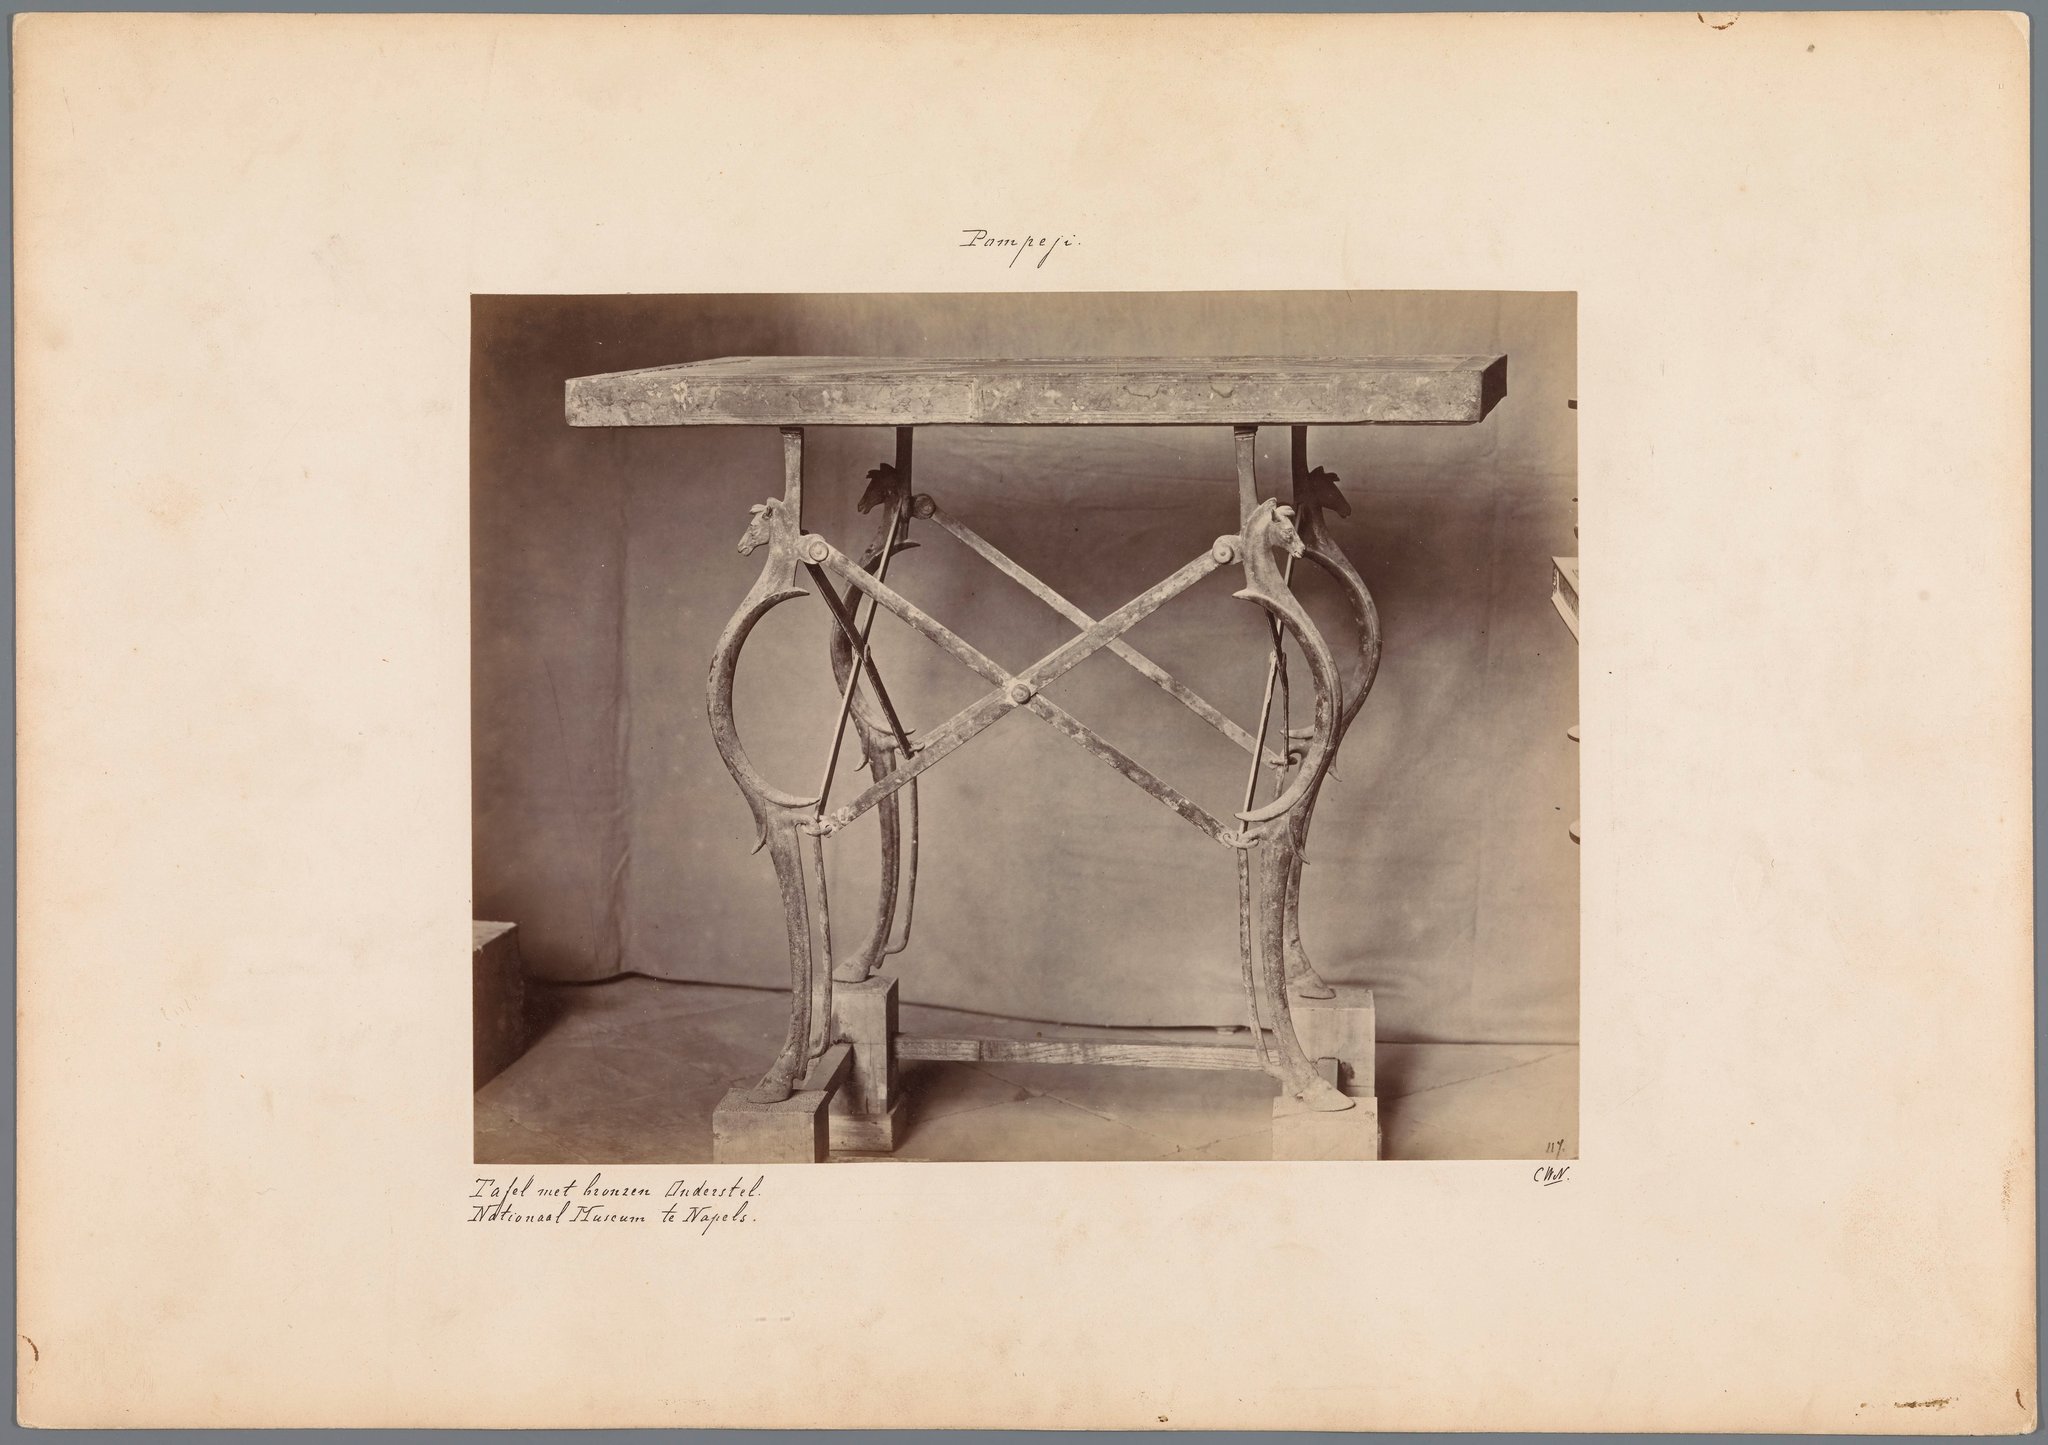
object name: photograph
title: Tafel met een bronzen onderstel, afkomstig uit Pompeï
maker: Anonymous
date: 1875-1900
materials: cardboard, photographic support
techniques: albumen print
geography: naples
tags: table, horse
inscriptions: name: ‘NJ.’, collector's mark: ‘KUNSTNIJVERHEIDSCHOOL QUELLINUS AMSTERDAM FRANS HALSSTRAAT 14.’, collector's mark: ‘INSTITUUT VOOR KUNST-NIJVERHEIDSONDERWIJS GABRIËL METSUSTRAAT No. 16. AMSTERDAM’, inscription: ‘CWN’, inscription: ‘Pompeji. Tafel met bronzen Onderstel. Nationaal Museum te Napels.’